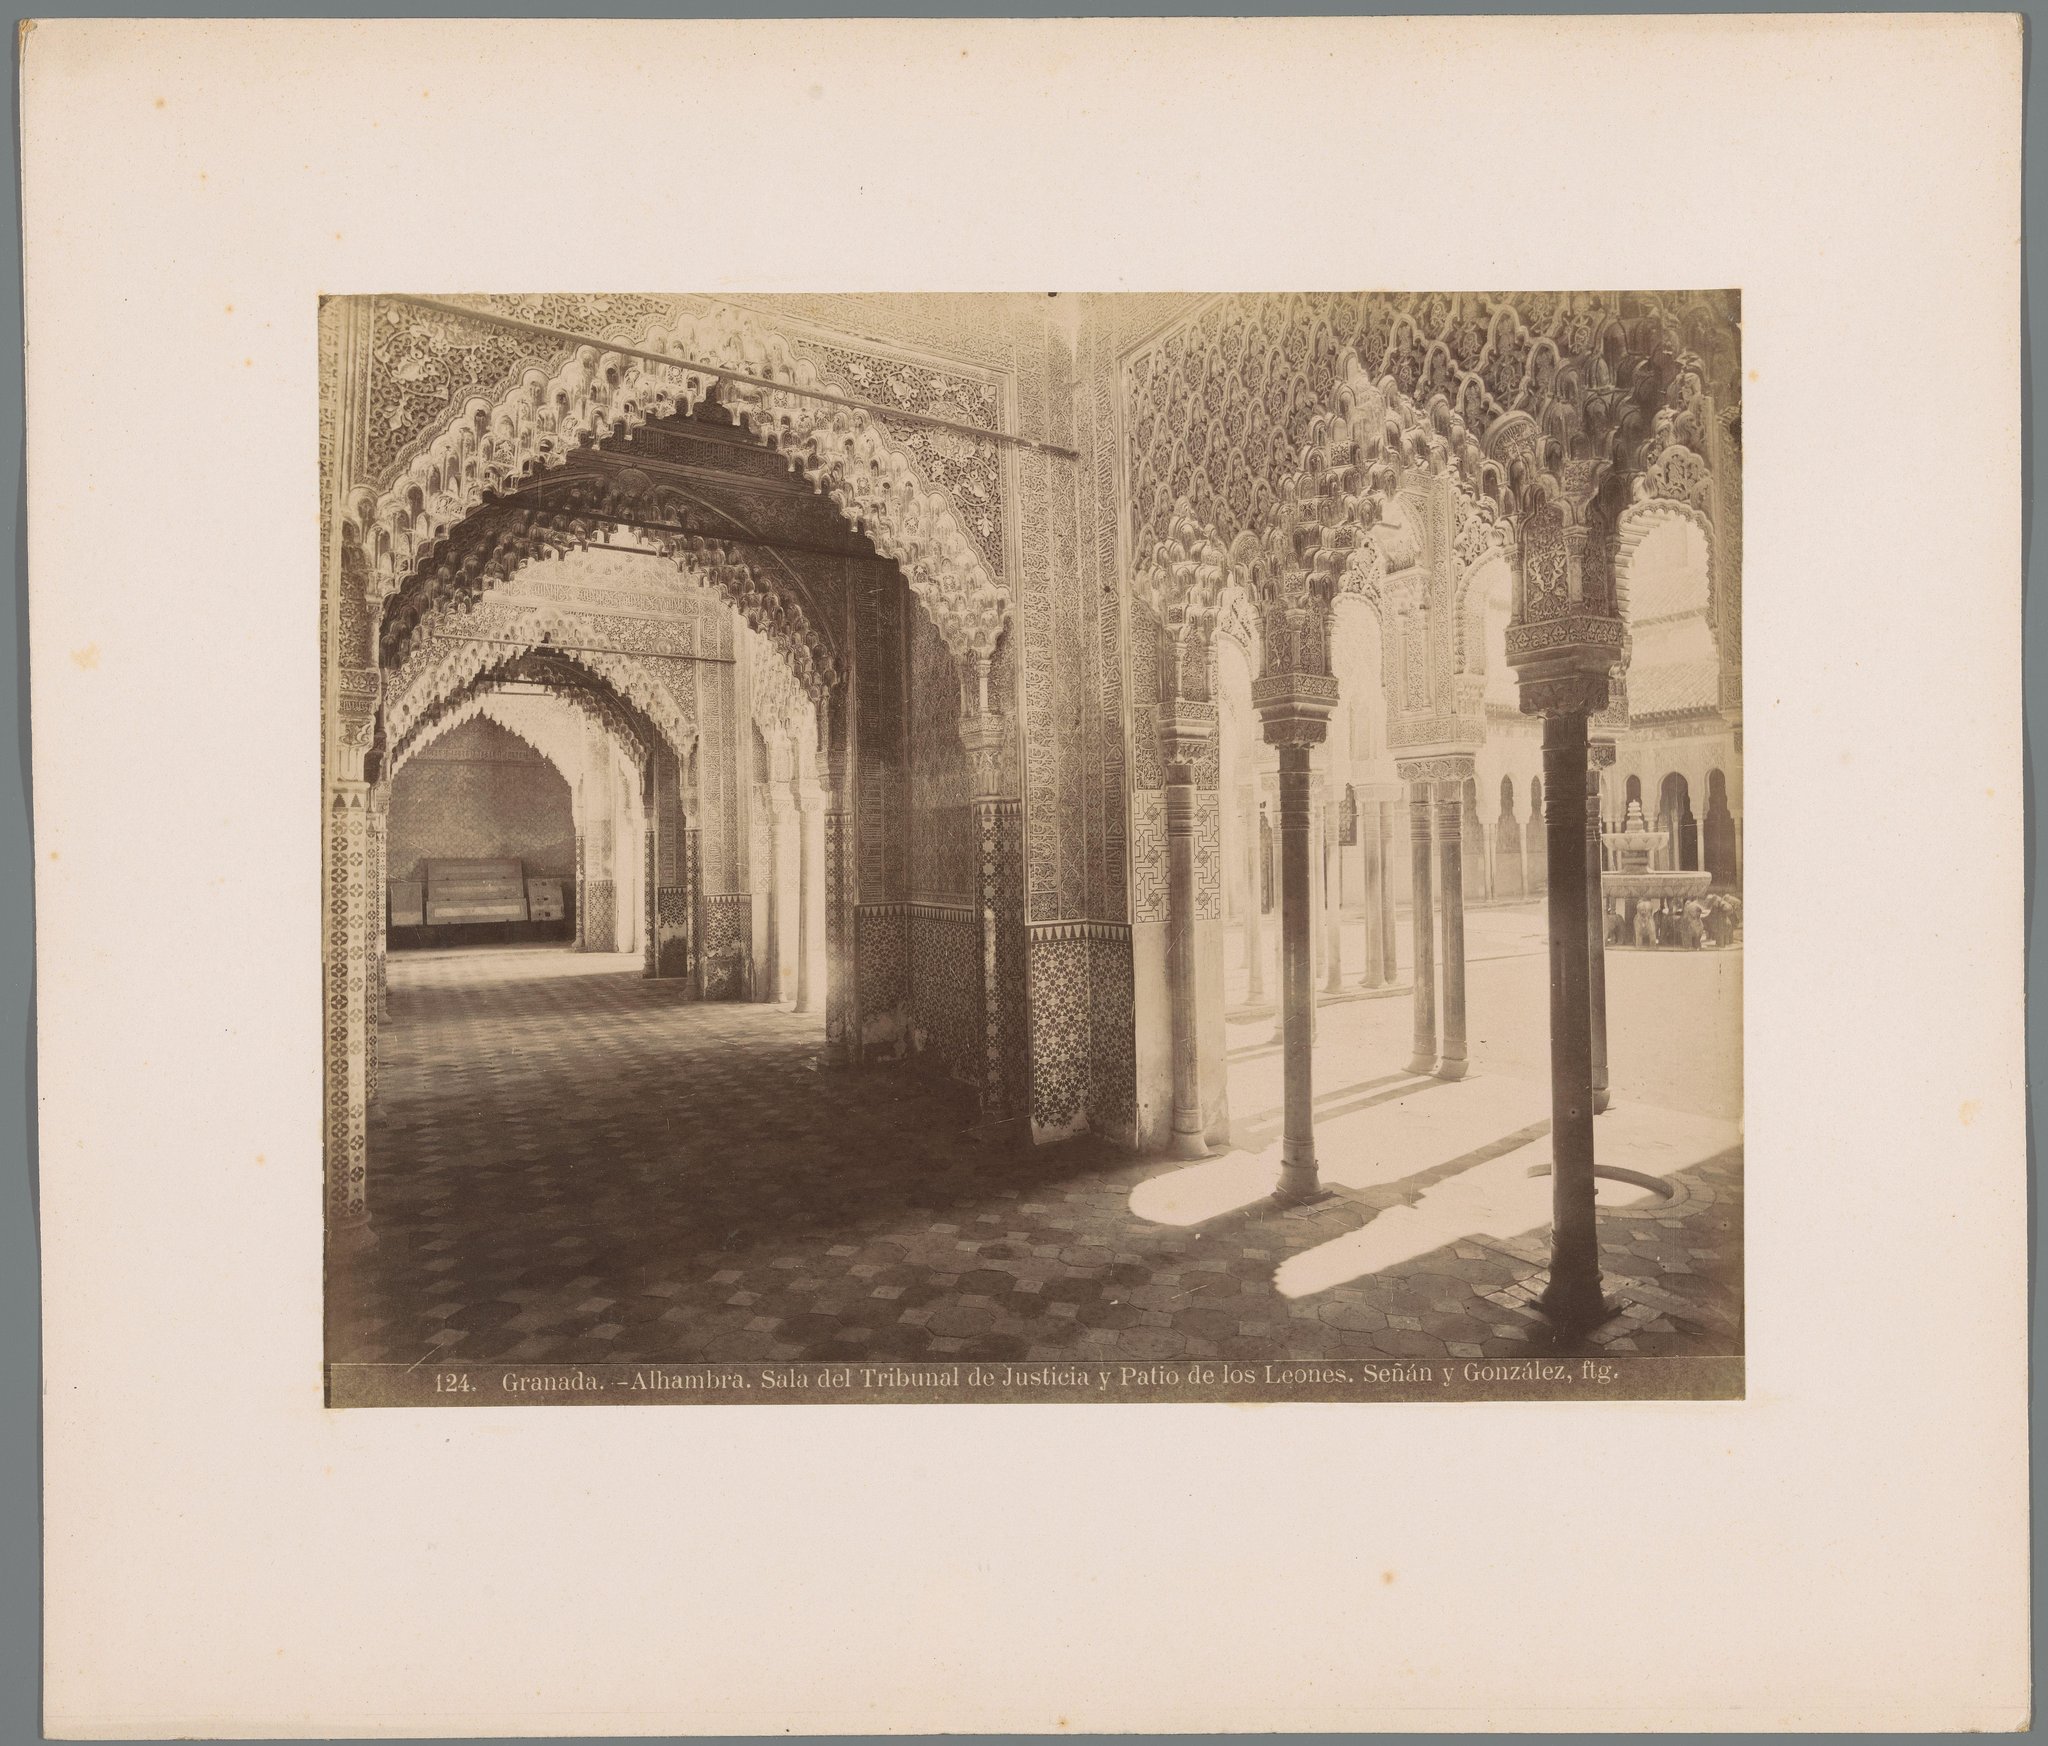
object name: photograph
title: Patio de los Leones met fontein in het Alhambra in Granada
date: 1880-1900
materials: cardboard, paper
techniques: albumen print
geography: granada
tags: courtyard, ornamental fountain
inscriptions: number: ‘124.’